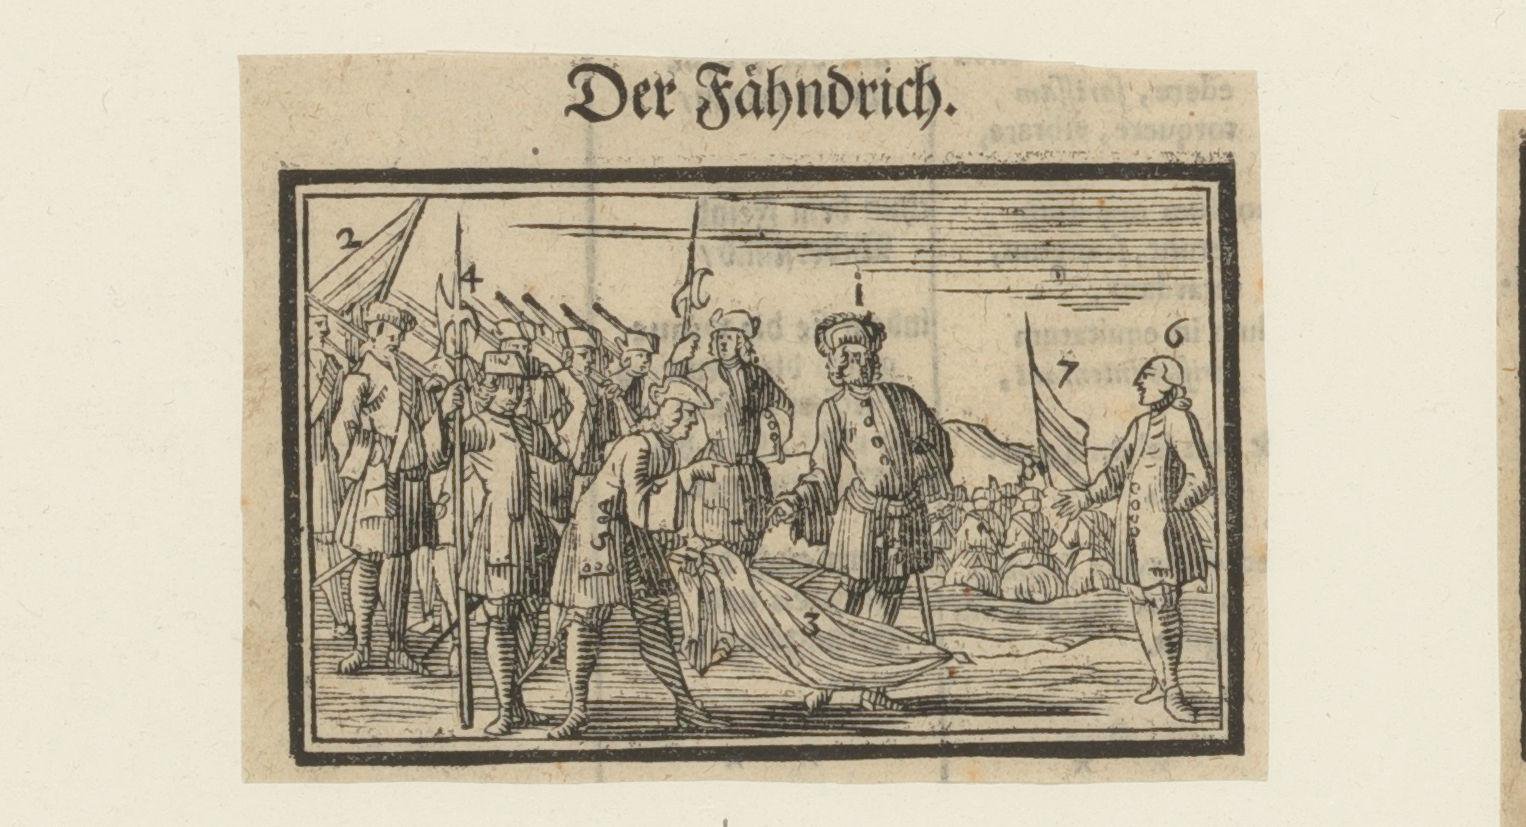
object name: print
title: Der Fähndrich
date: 1719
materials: paper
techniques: letterpress printing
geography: nuremberg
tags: handicrafts, craftsman at work, standard-bearer, flag-bearer, (military) flags and standards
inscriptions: stamp, collector's mark: Lugt 1641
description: Prent uit: Comenius, Johannes Amosius. Orbis sensualium picti pars prima (...). Neurenberg: Martin Endter, 1719, dl. 2, p. 292. Prent eerder gebruikt in: Comenius, Johannes Amosius. Orbis Sensualium Picti denuo aucti Pars Secunda (...). Neurenberg: Martin Endter, 1730, dl. 2.